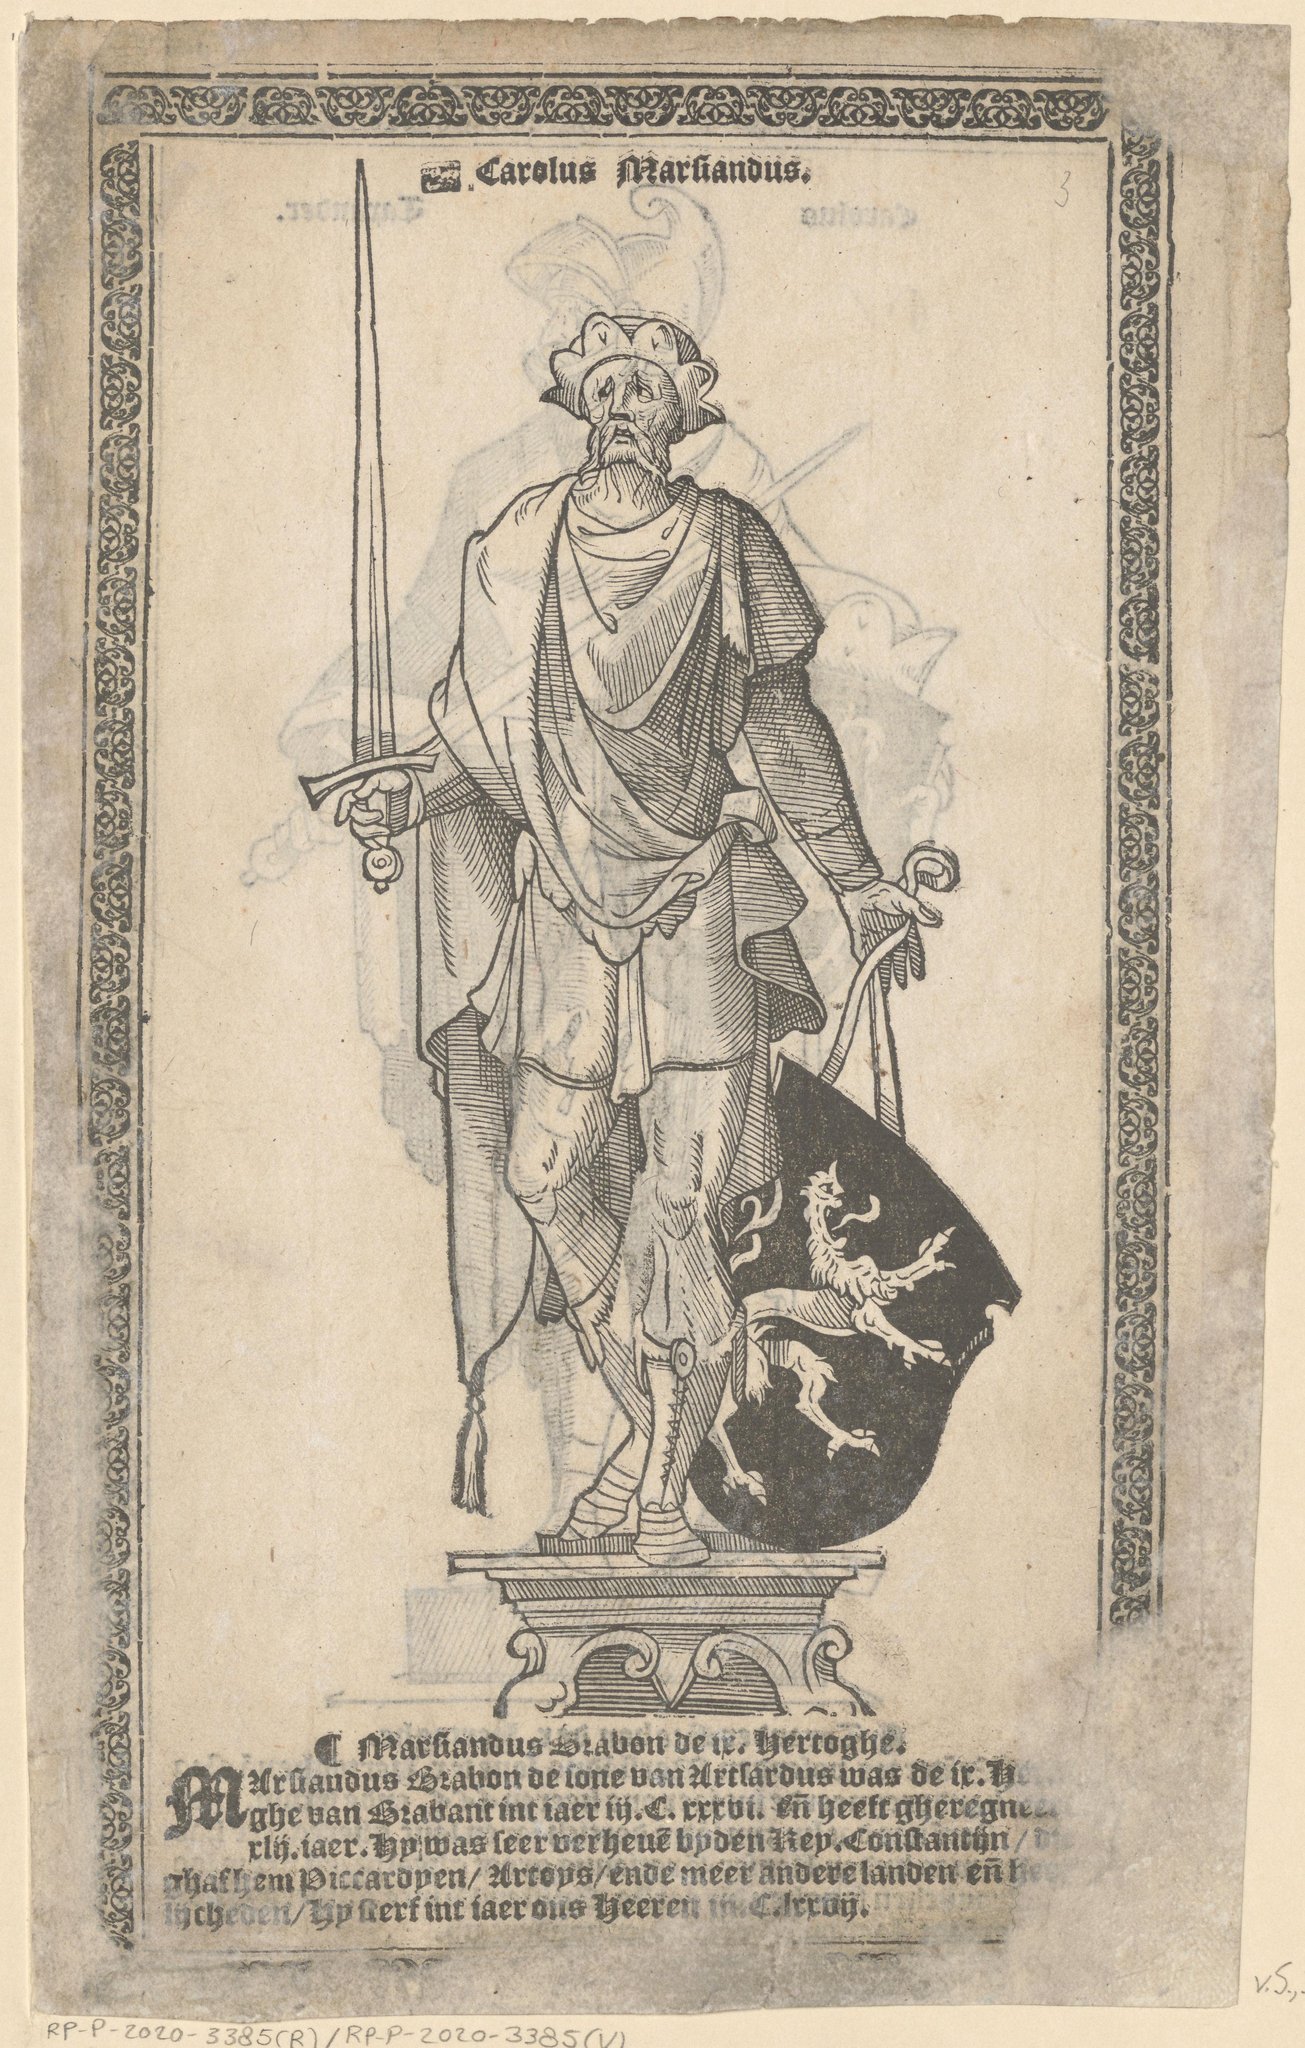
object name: print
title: Portret van Marsiandus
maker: jan molijns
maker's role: print maker, publisher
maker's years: 1498-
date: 1565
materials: paper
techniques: letterpress printing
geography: antwerp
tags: hacking and thrusting weapons: sword, armorial bearing, heraldry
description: Prent uit: Dit is die afcoemste ende genalogie der hertoghen ende hertoginnen van Brabandt, (...). Antwerpen: Jan Molijns, 1565.